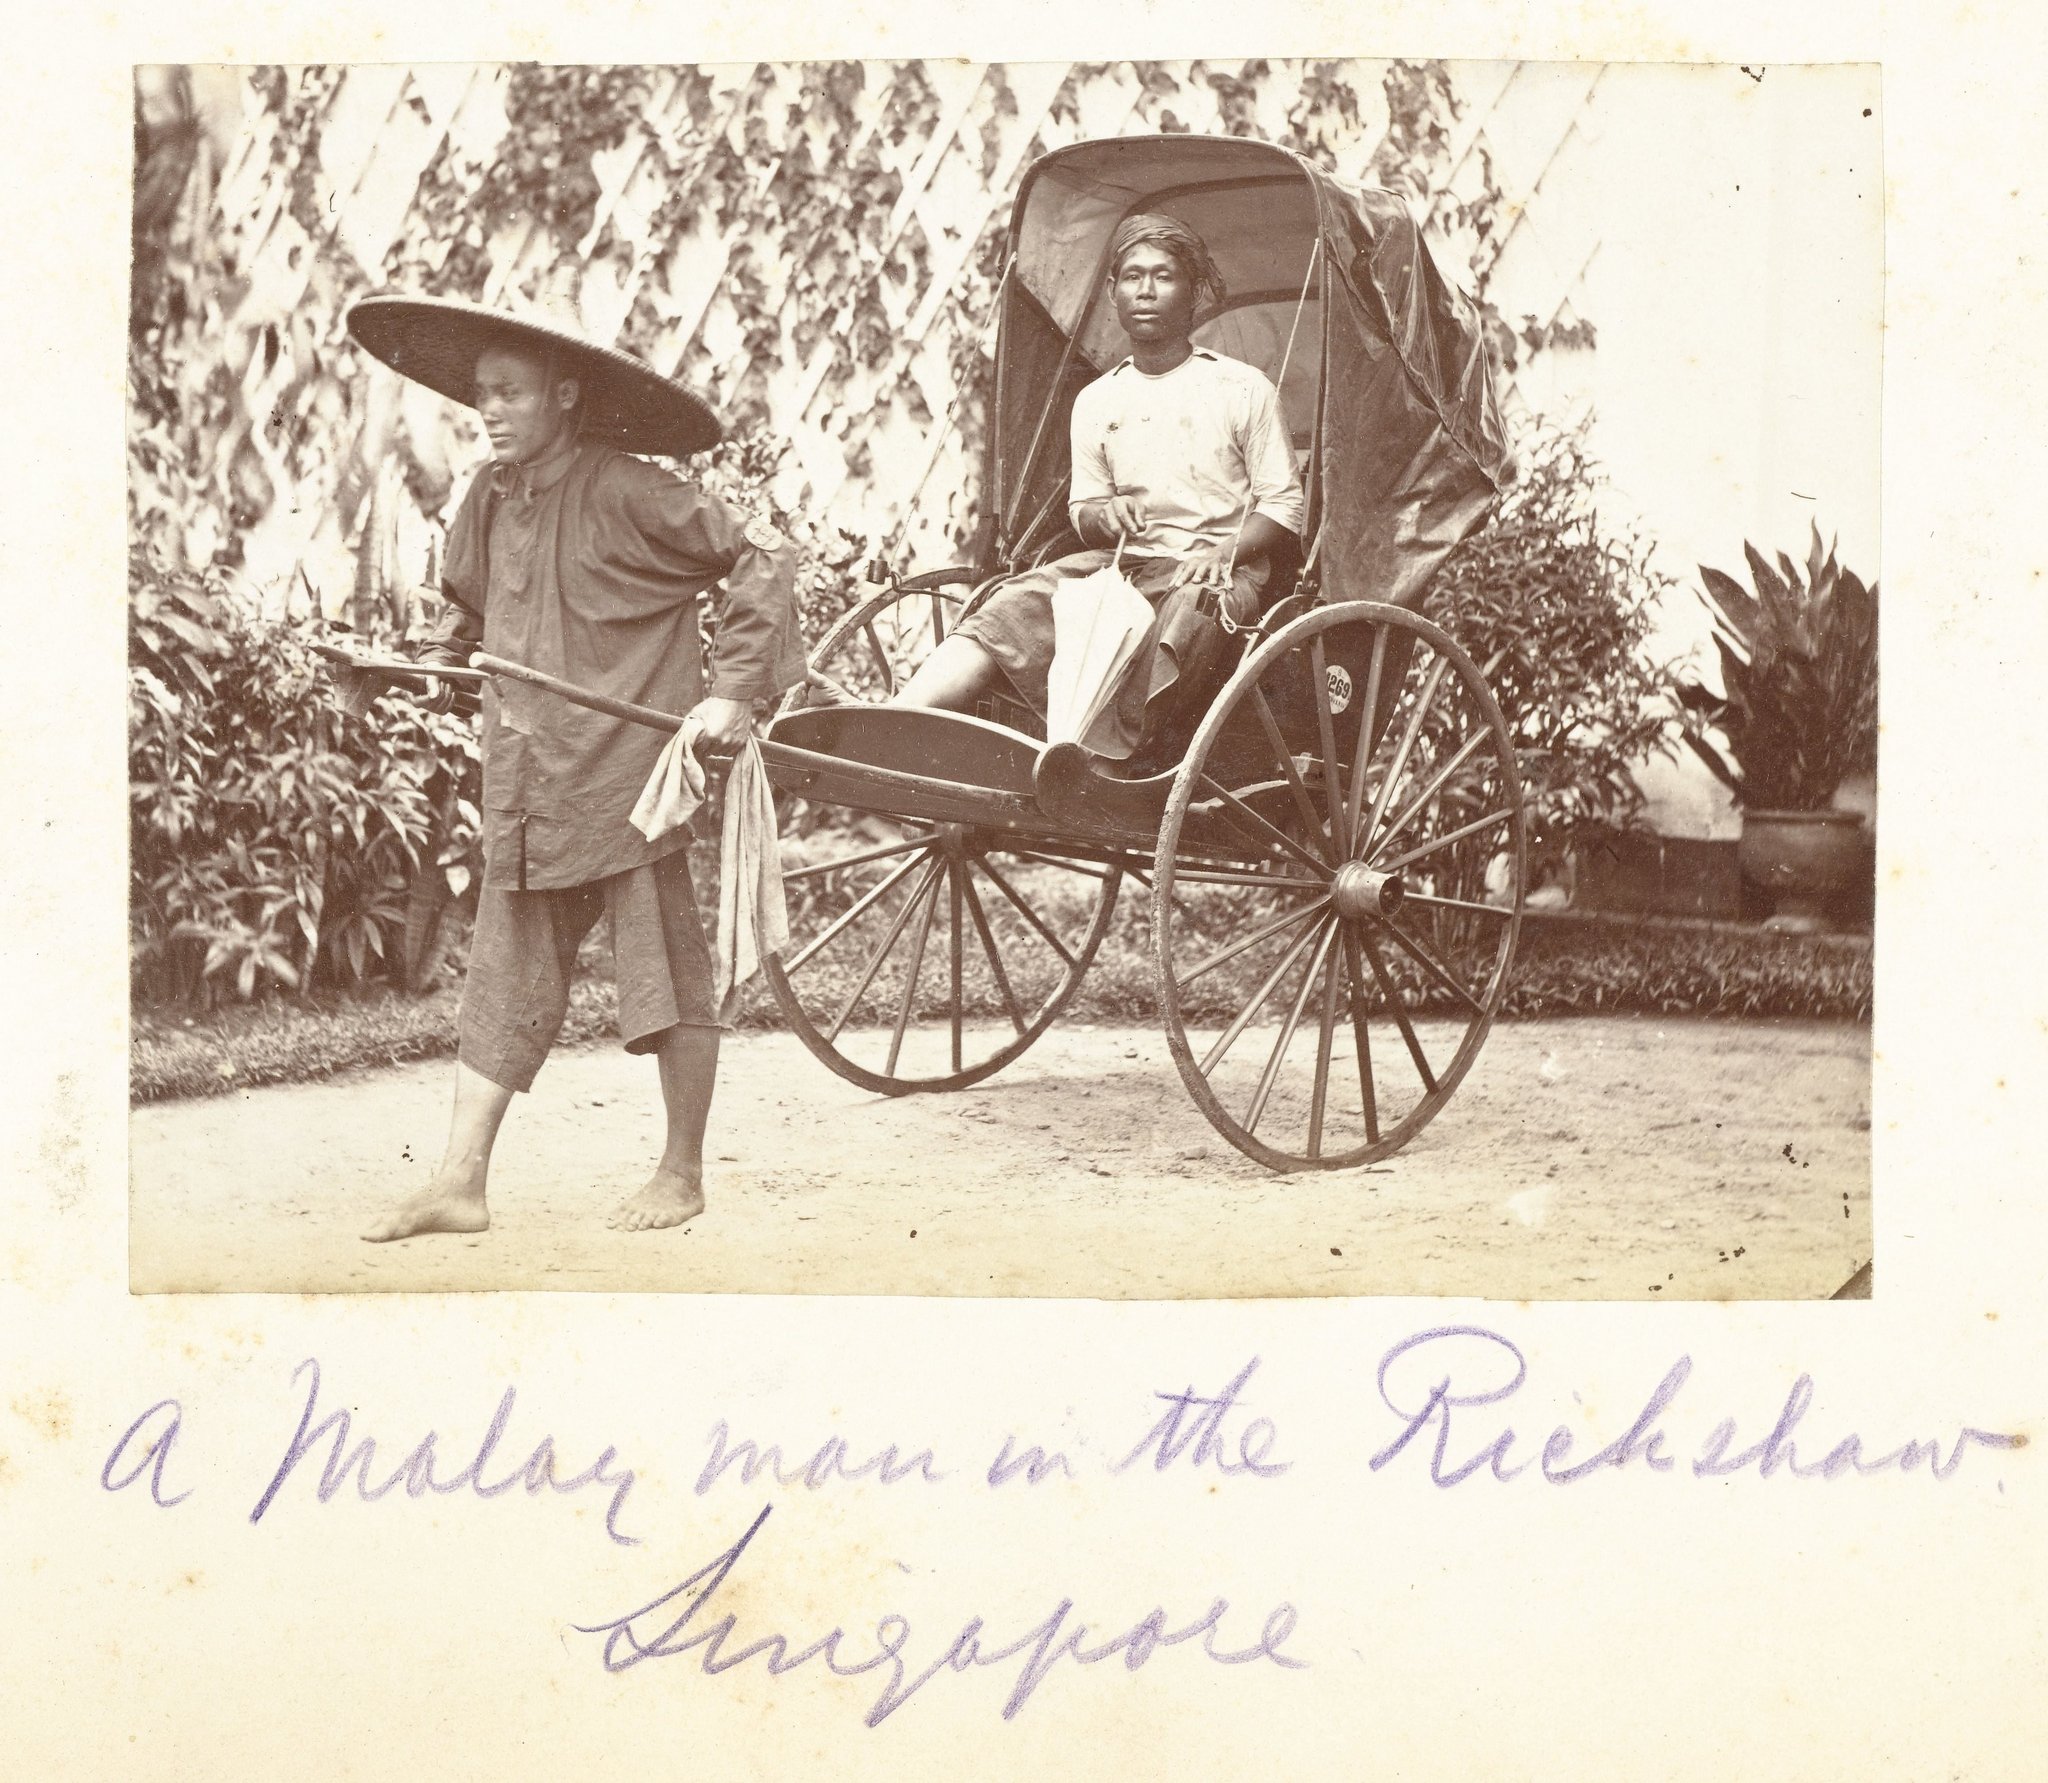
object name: photograph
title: A Malay man in the Rickshaw Singapore.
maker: Anonymous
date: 1890-1910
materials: cardboard, paper, photographic support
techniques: gelatin silver print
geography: netherlands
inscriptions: caption: ‘A Malay man in the Rickshaw Singapore.’